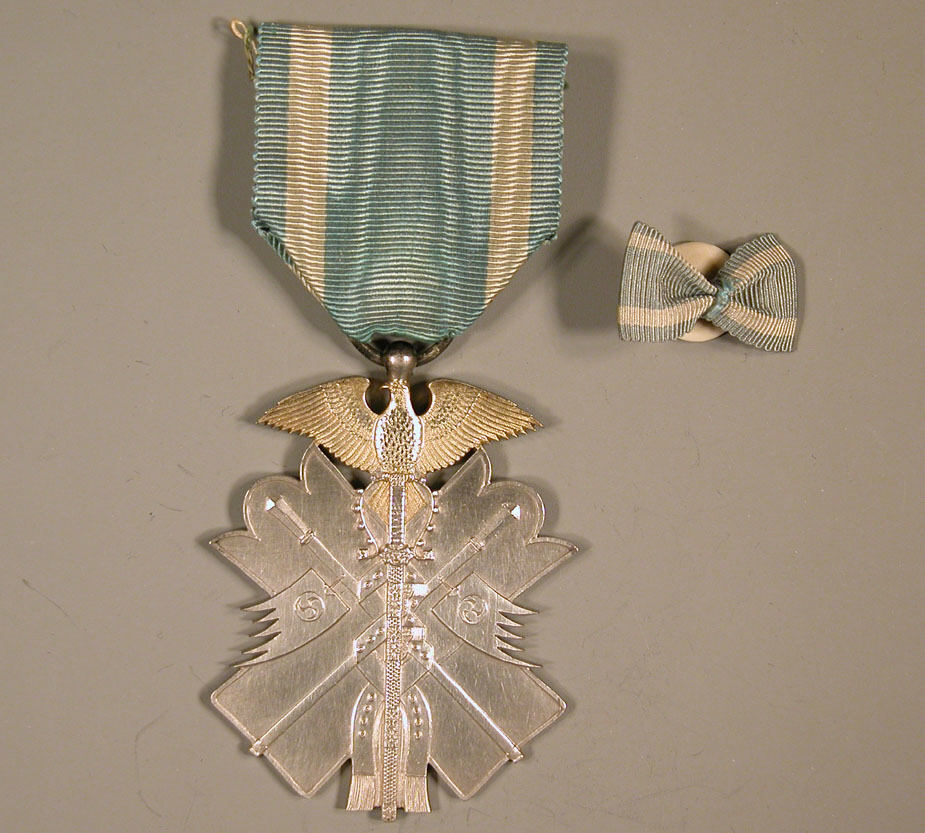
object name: medal and button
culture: japanese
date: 1867-1900